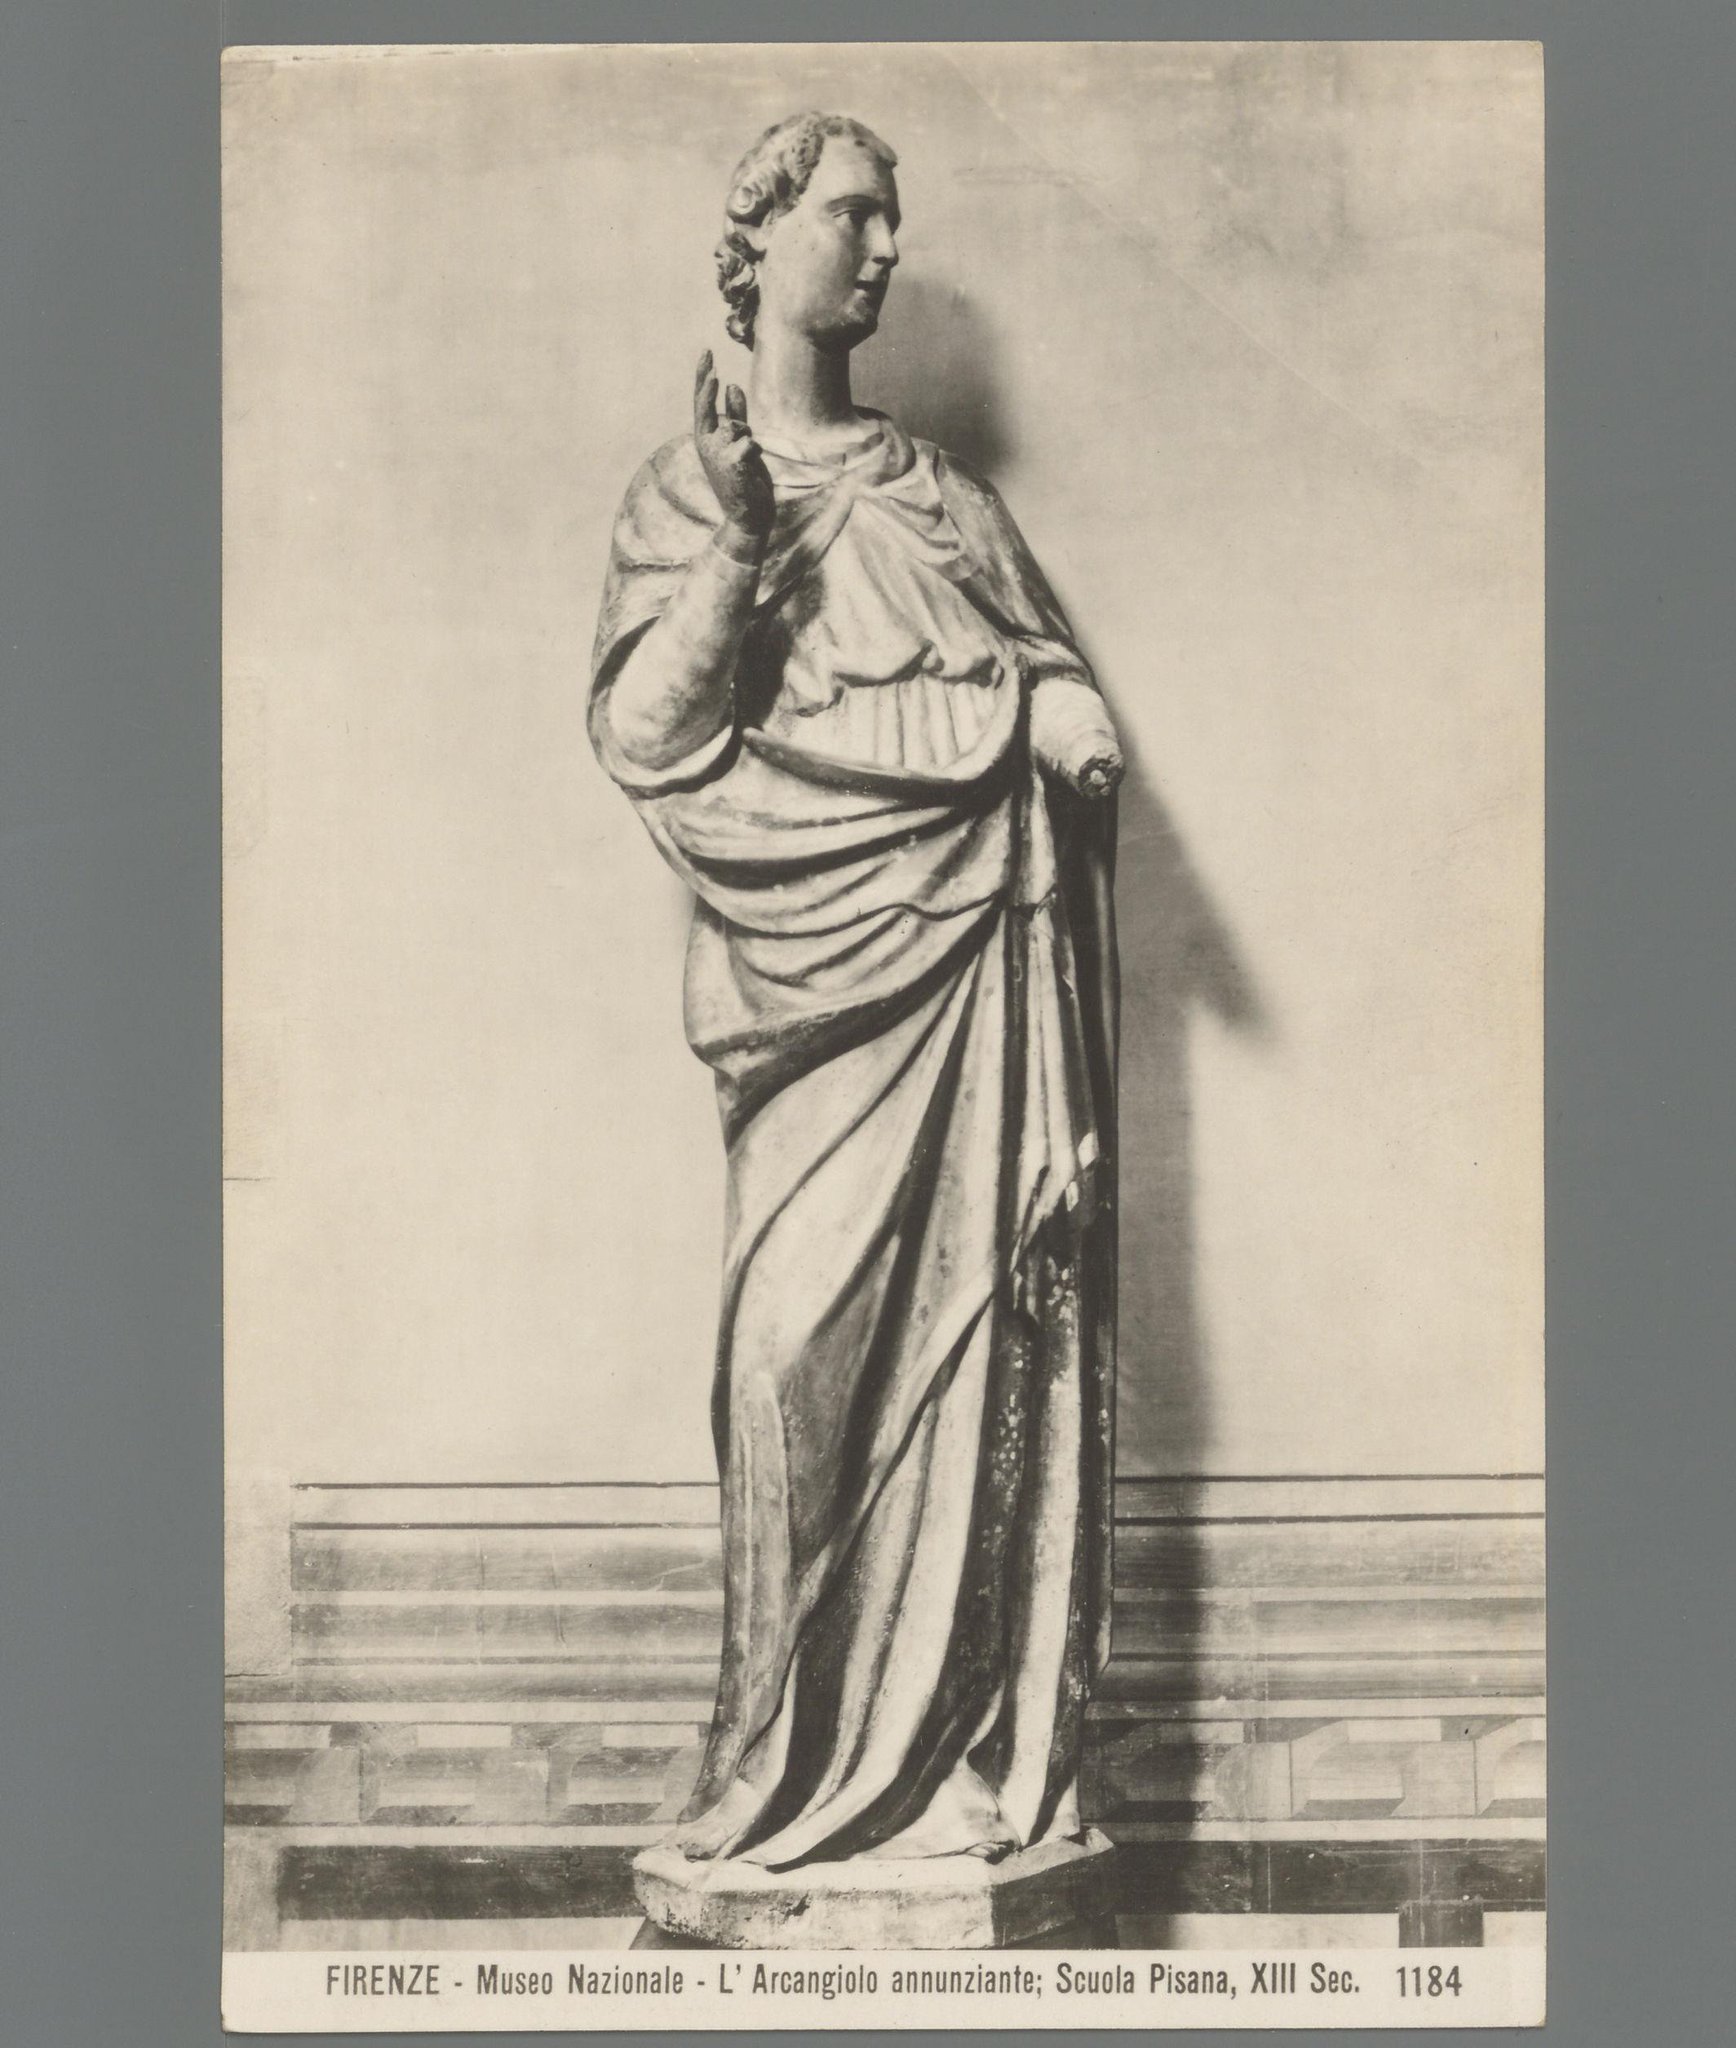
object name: ansichtkaart, prentbriefkaart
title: Firenze. Museo Nazionale. L'Arcangiolo annunziante; Scuola Pisana, XIII Sec.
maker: Anonymous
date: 1906-1930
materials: photographic support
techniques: photography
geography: florence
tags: sculpture, angels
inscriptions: collector's mark: ‘AFE v S’